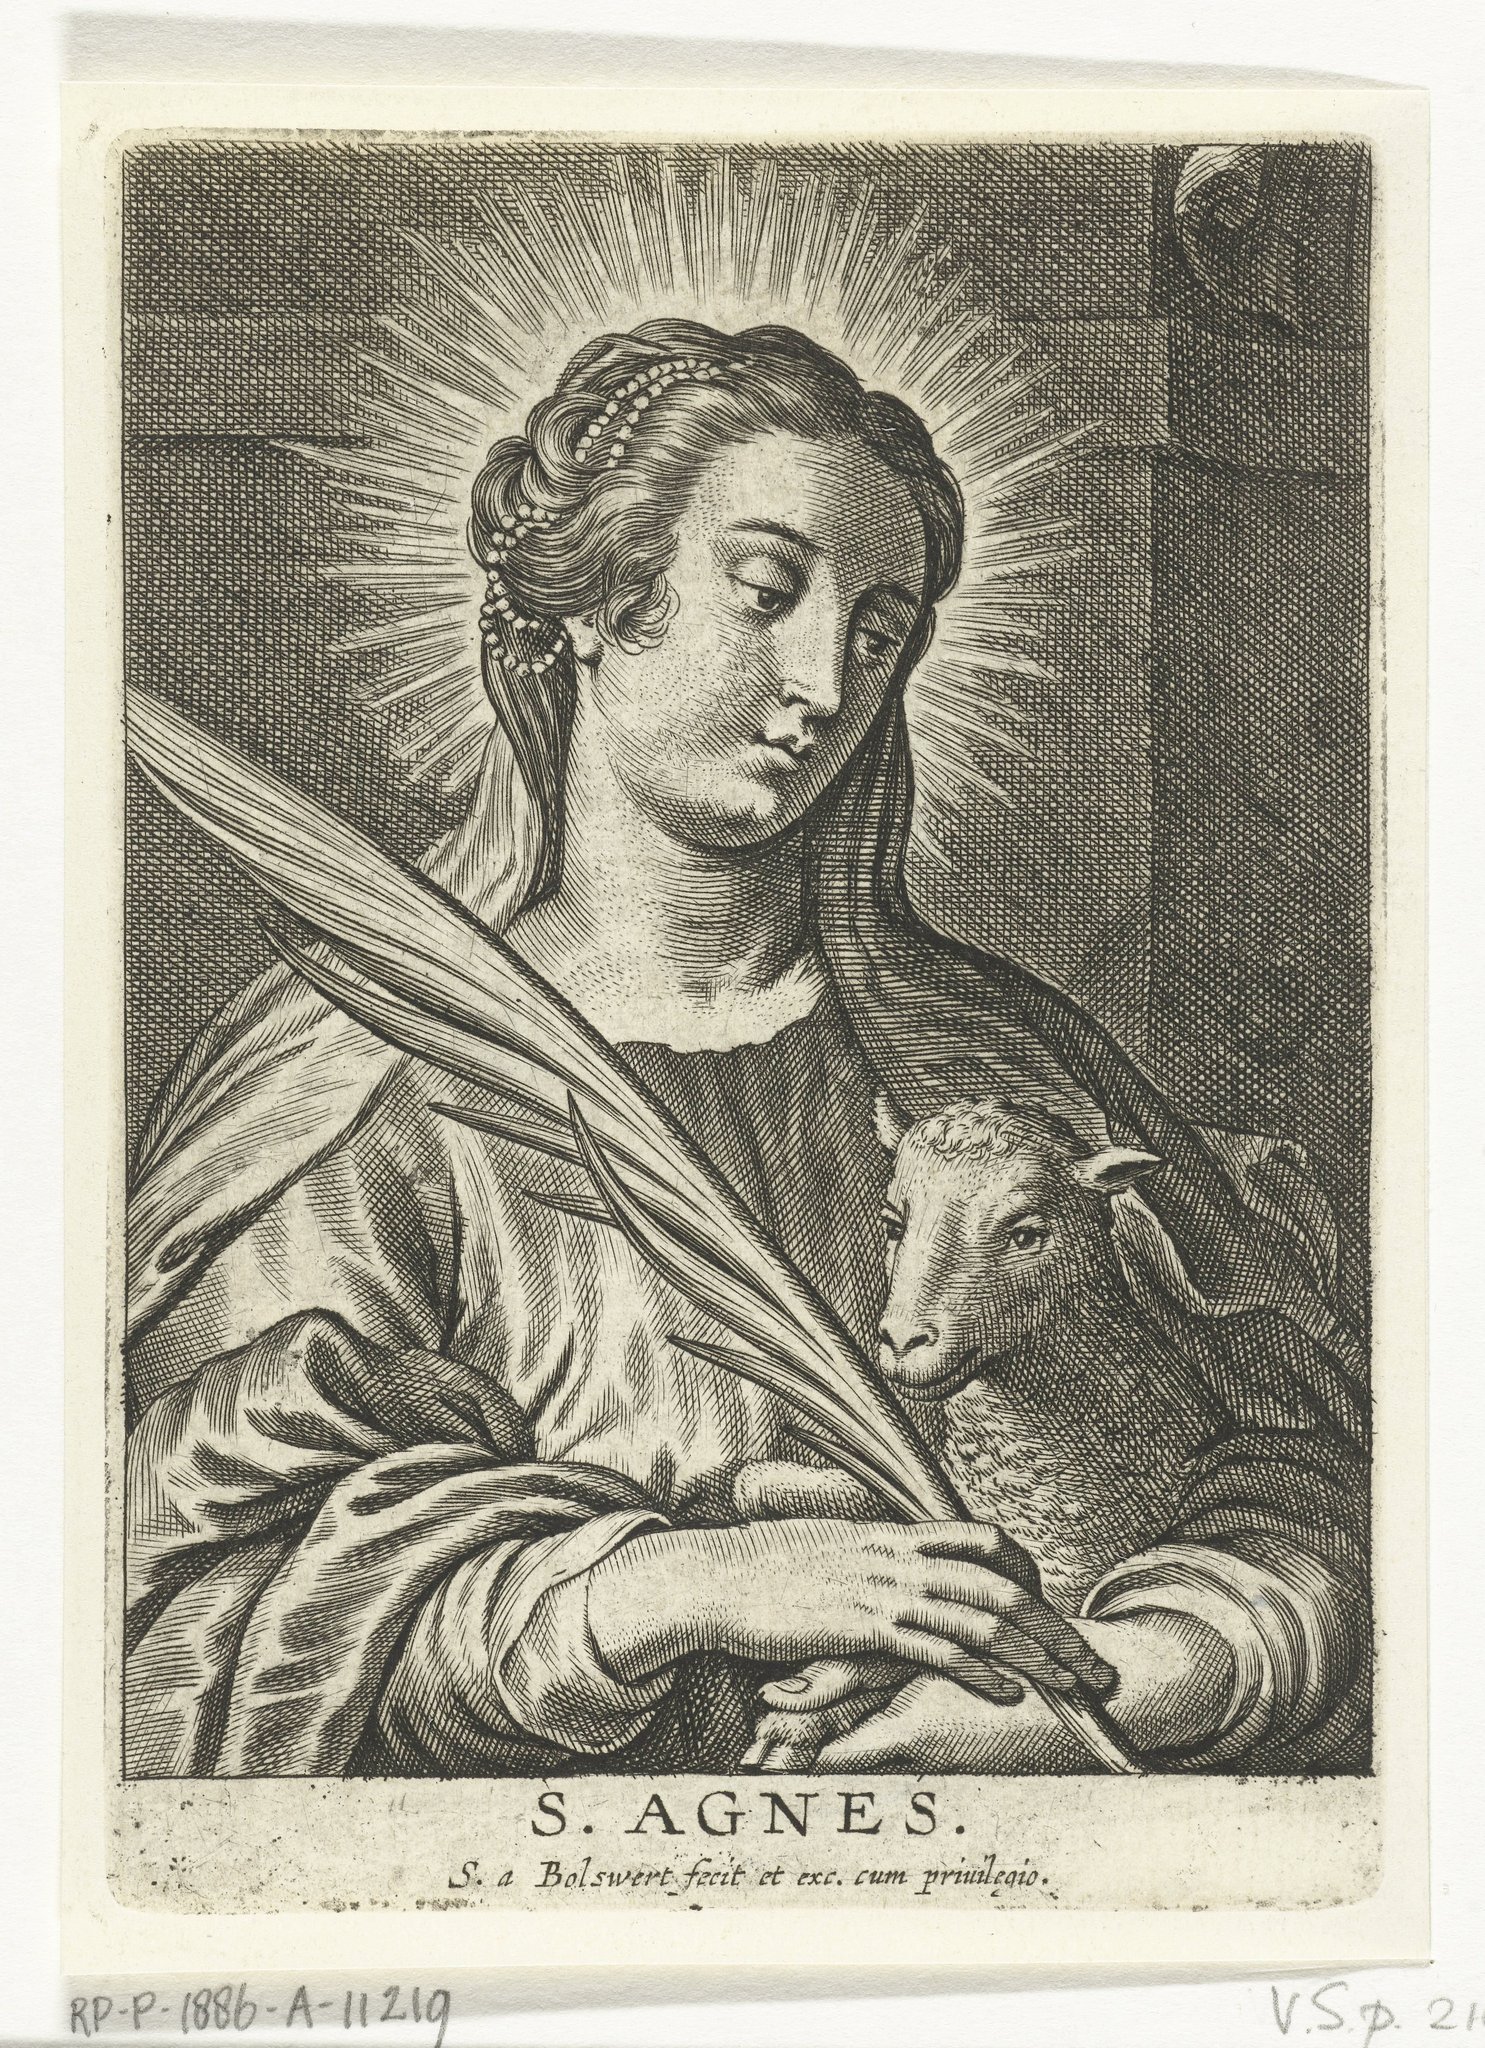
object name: print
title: Heilige Agnes met lam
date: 1596-1659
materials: paper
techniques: engraving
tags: the virgin martyr agnes of rome; possible attributes: lamb, ring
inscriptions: collector's mark: Lugt 2228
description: Prent naar ontwerp van Peter Paul Rubens.